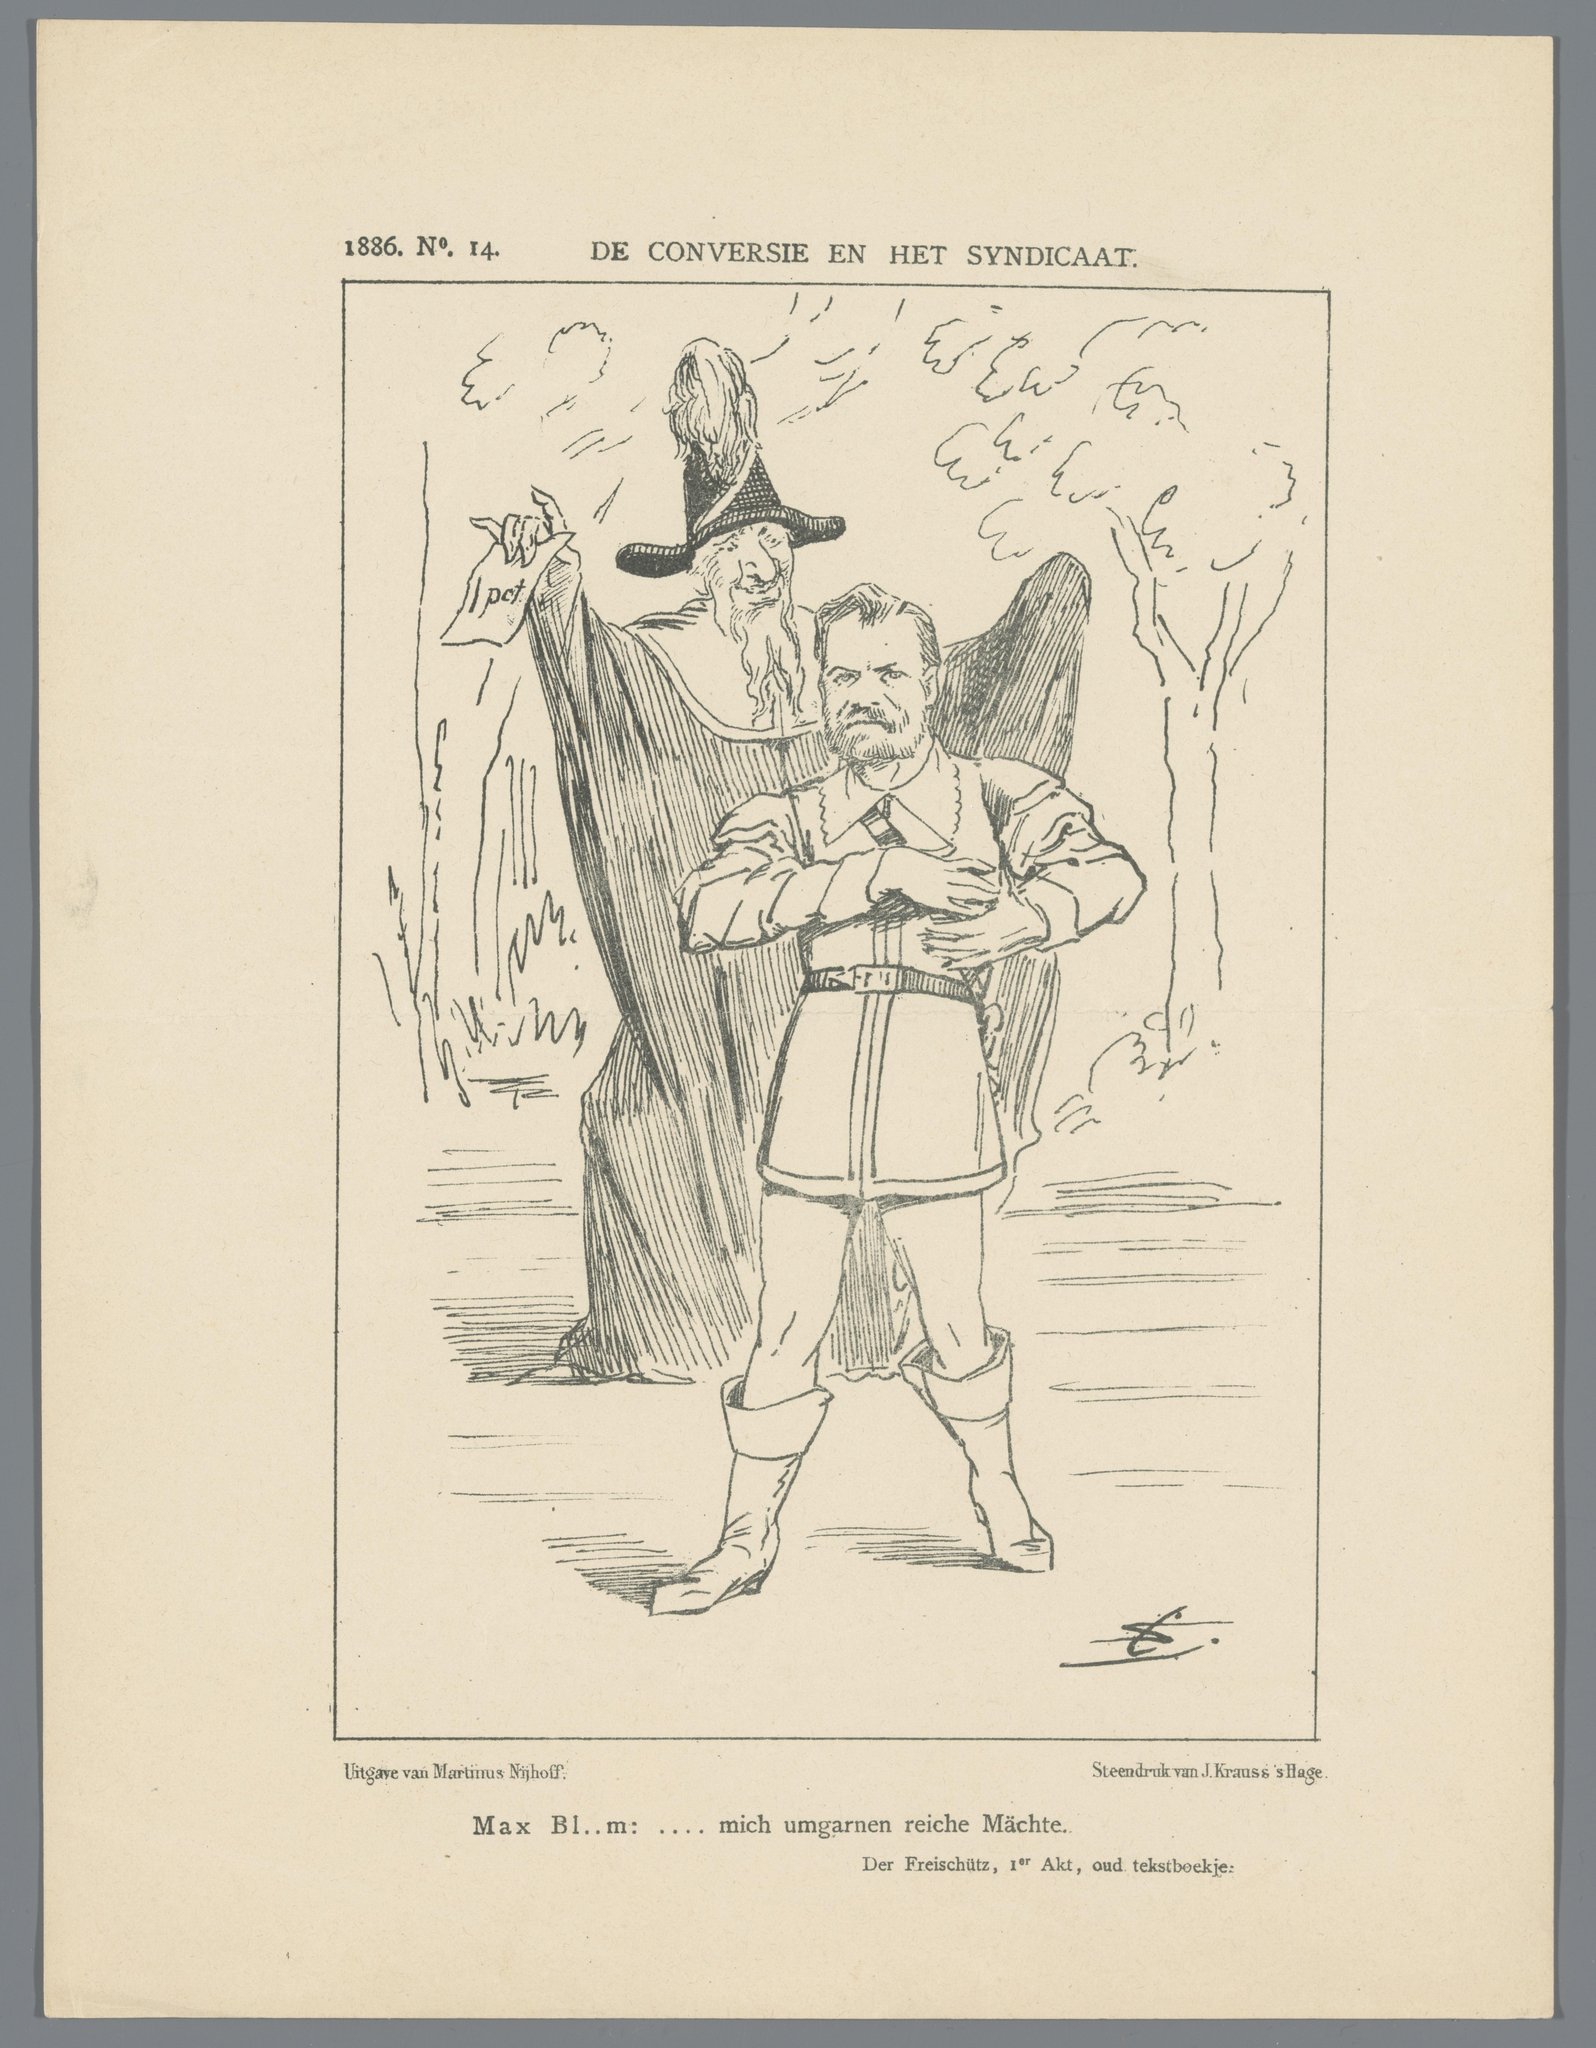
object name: cartoon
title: Spotprent met Minister Bloem, 1886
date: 1886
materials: paper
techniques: lithograph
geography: the hague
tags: minister van financiën, jacobus cornelis bloem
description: Spotprent met Minister van Financiën Bloem. Plaat verschenen bij het weekblad De Nederlandsche Spectator, nr. 14, 1886.